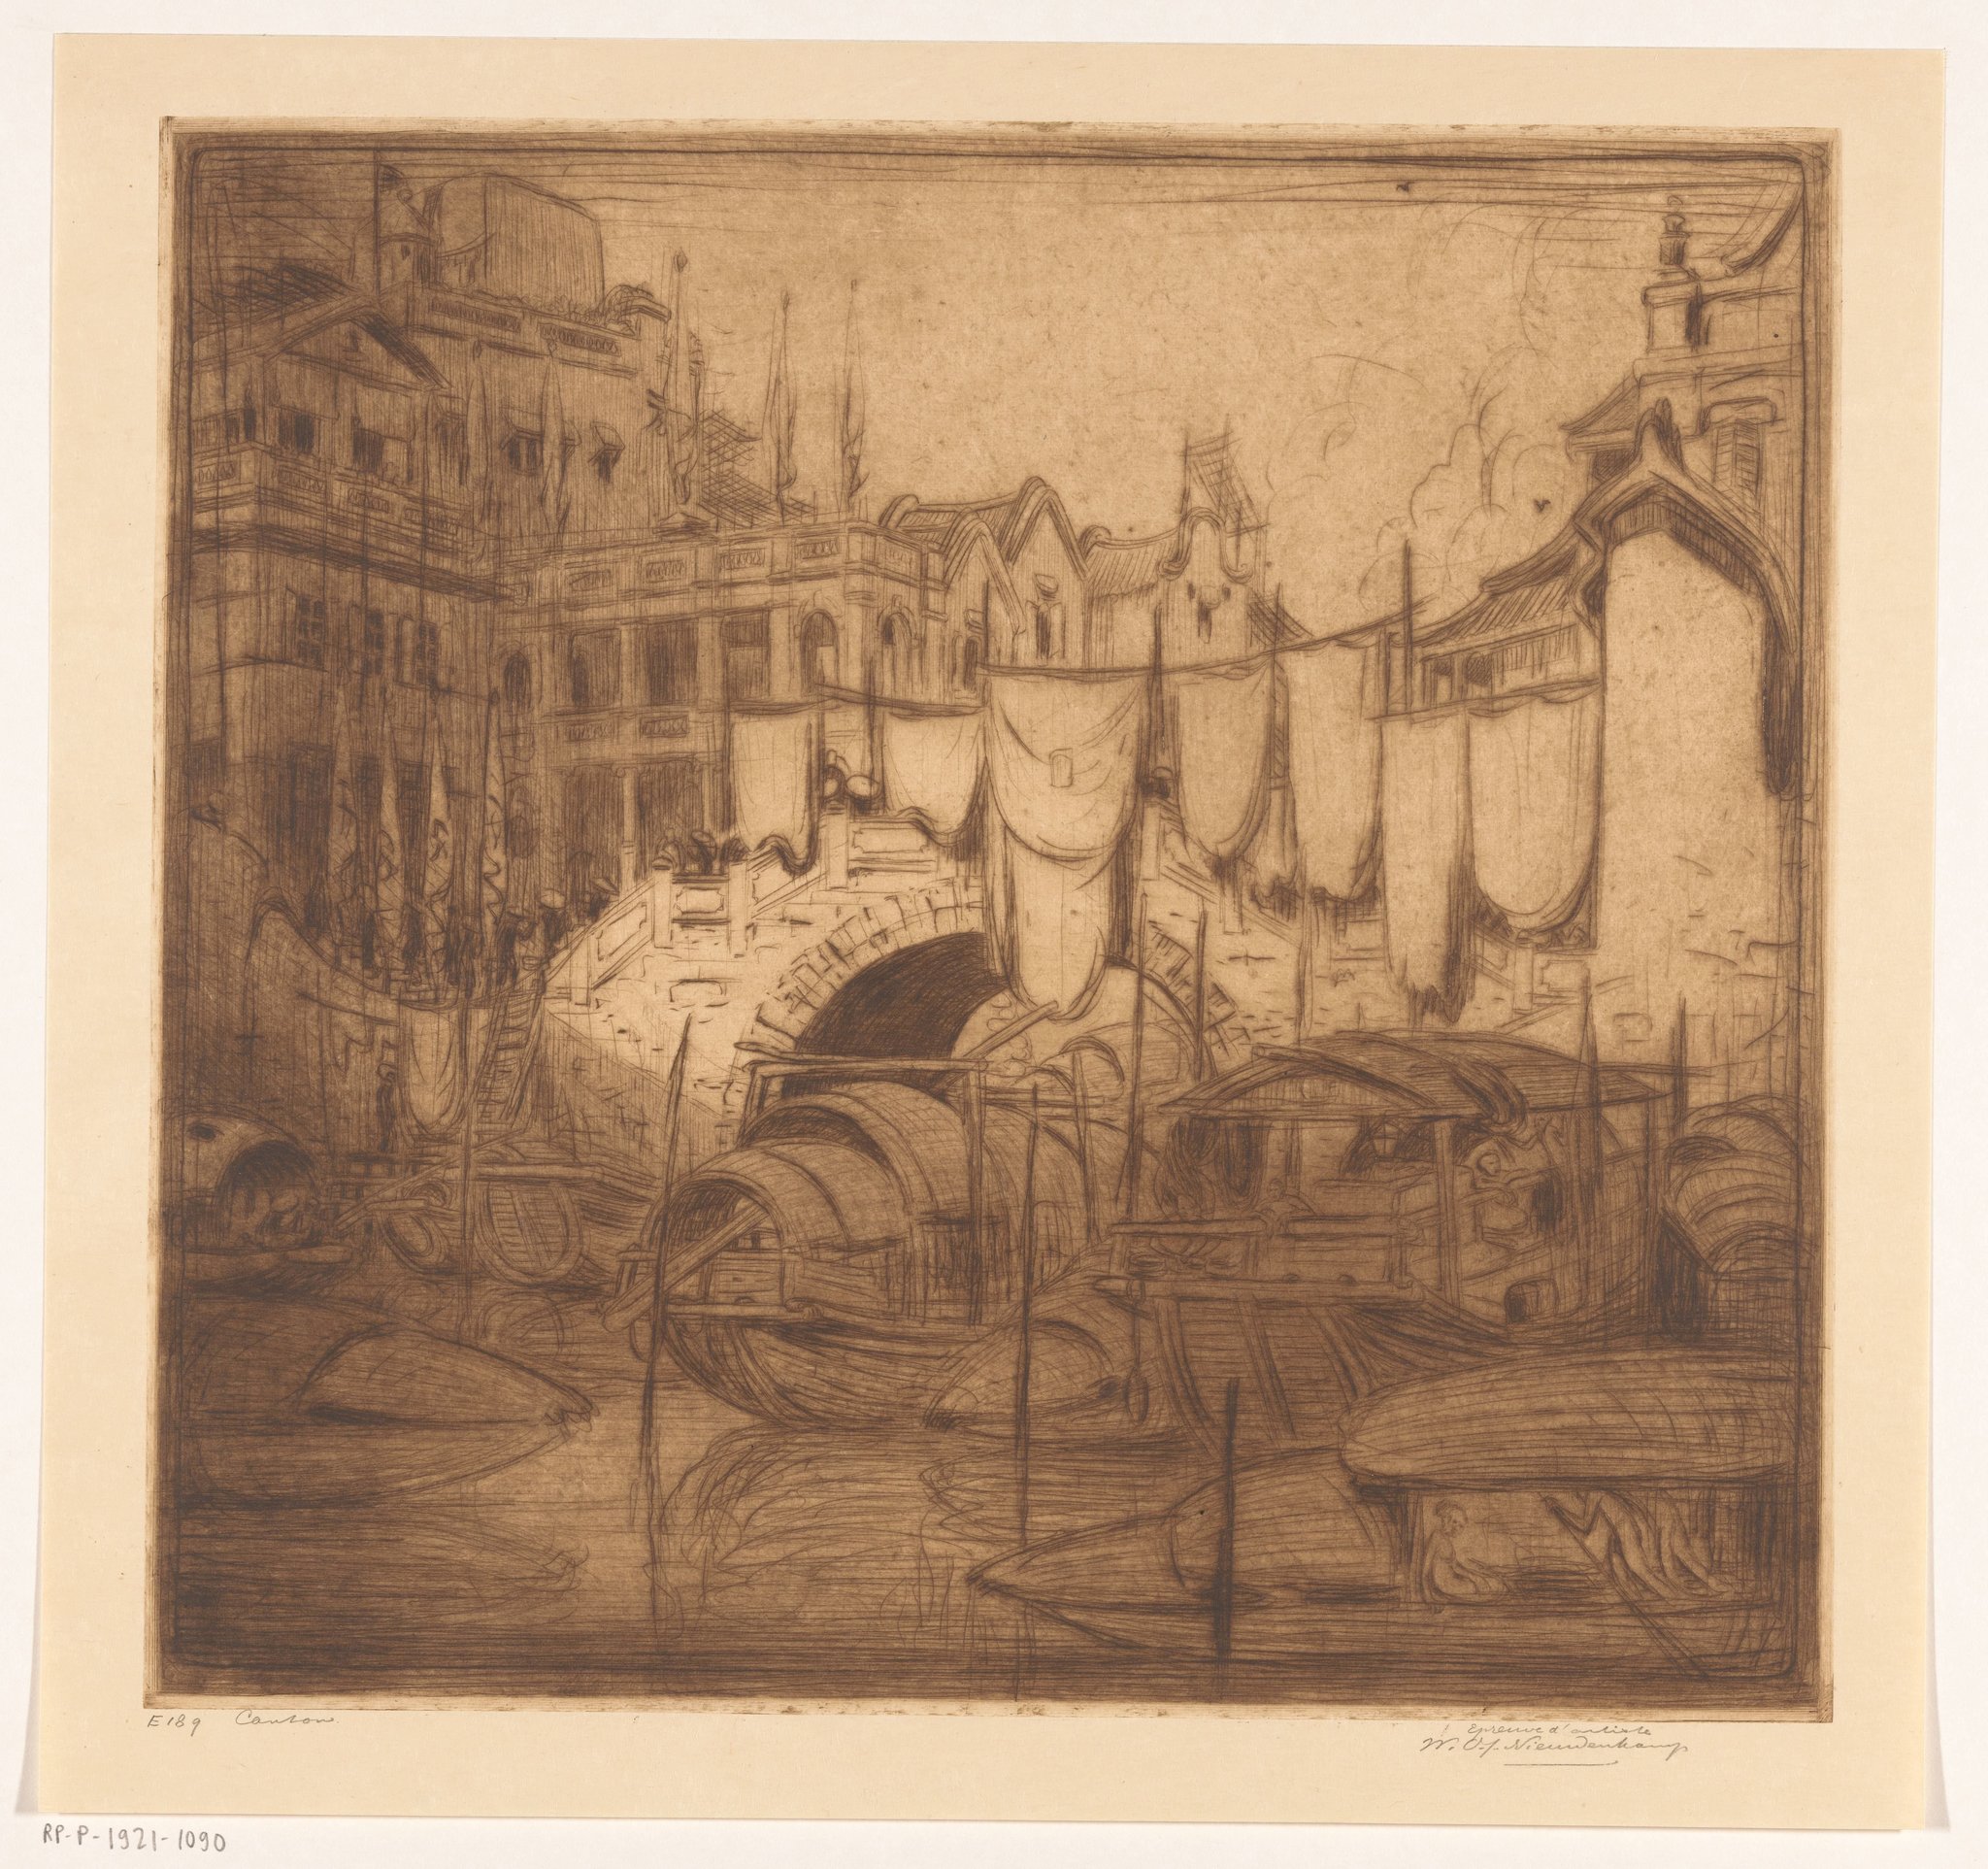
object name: print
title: Canton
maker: wijnand otto jan nieuwenkamp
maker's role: draughtsman, print maker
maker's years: 1874-1950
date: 1917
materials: paper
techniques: drypoint, intaglio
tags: bridge in city across river, canal, etc.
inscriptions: collector's mark: Lugt 2233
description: Op de voorgrond schepen in het water. Op de achtergrond huizen.